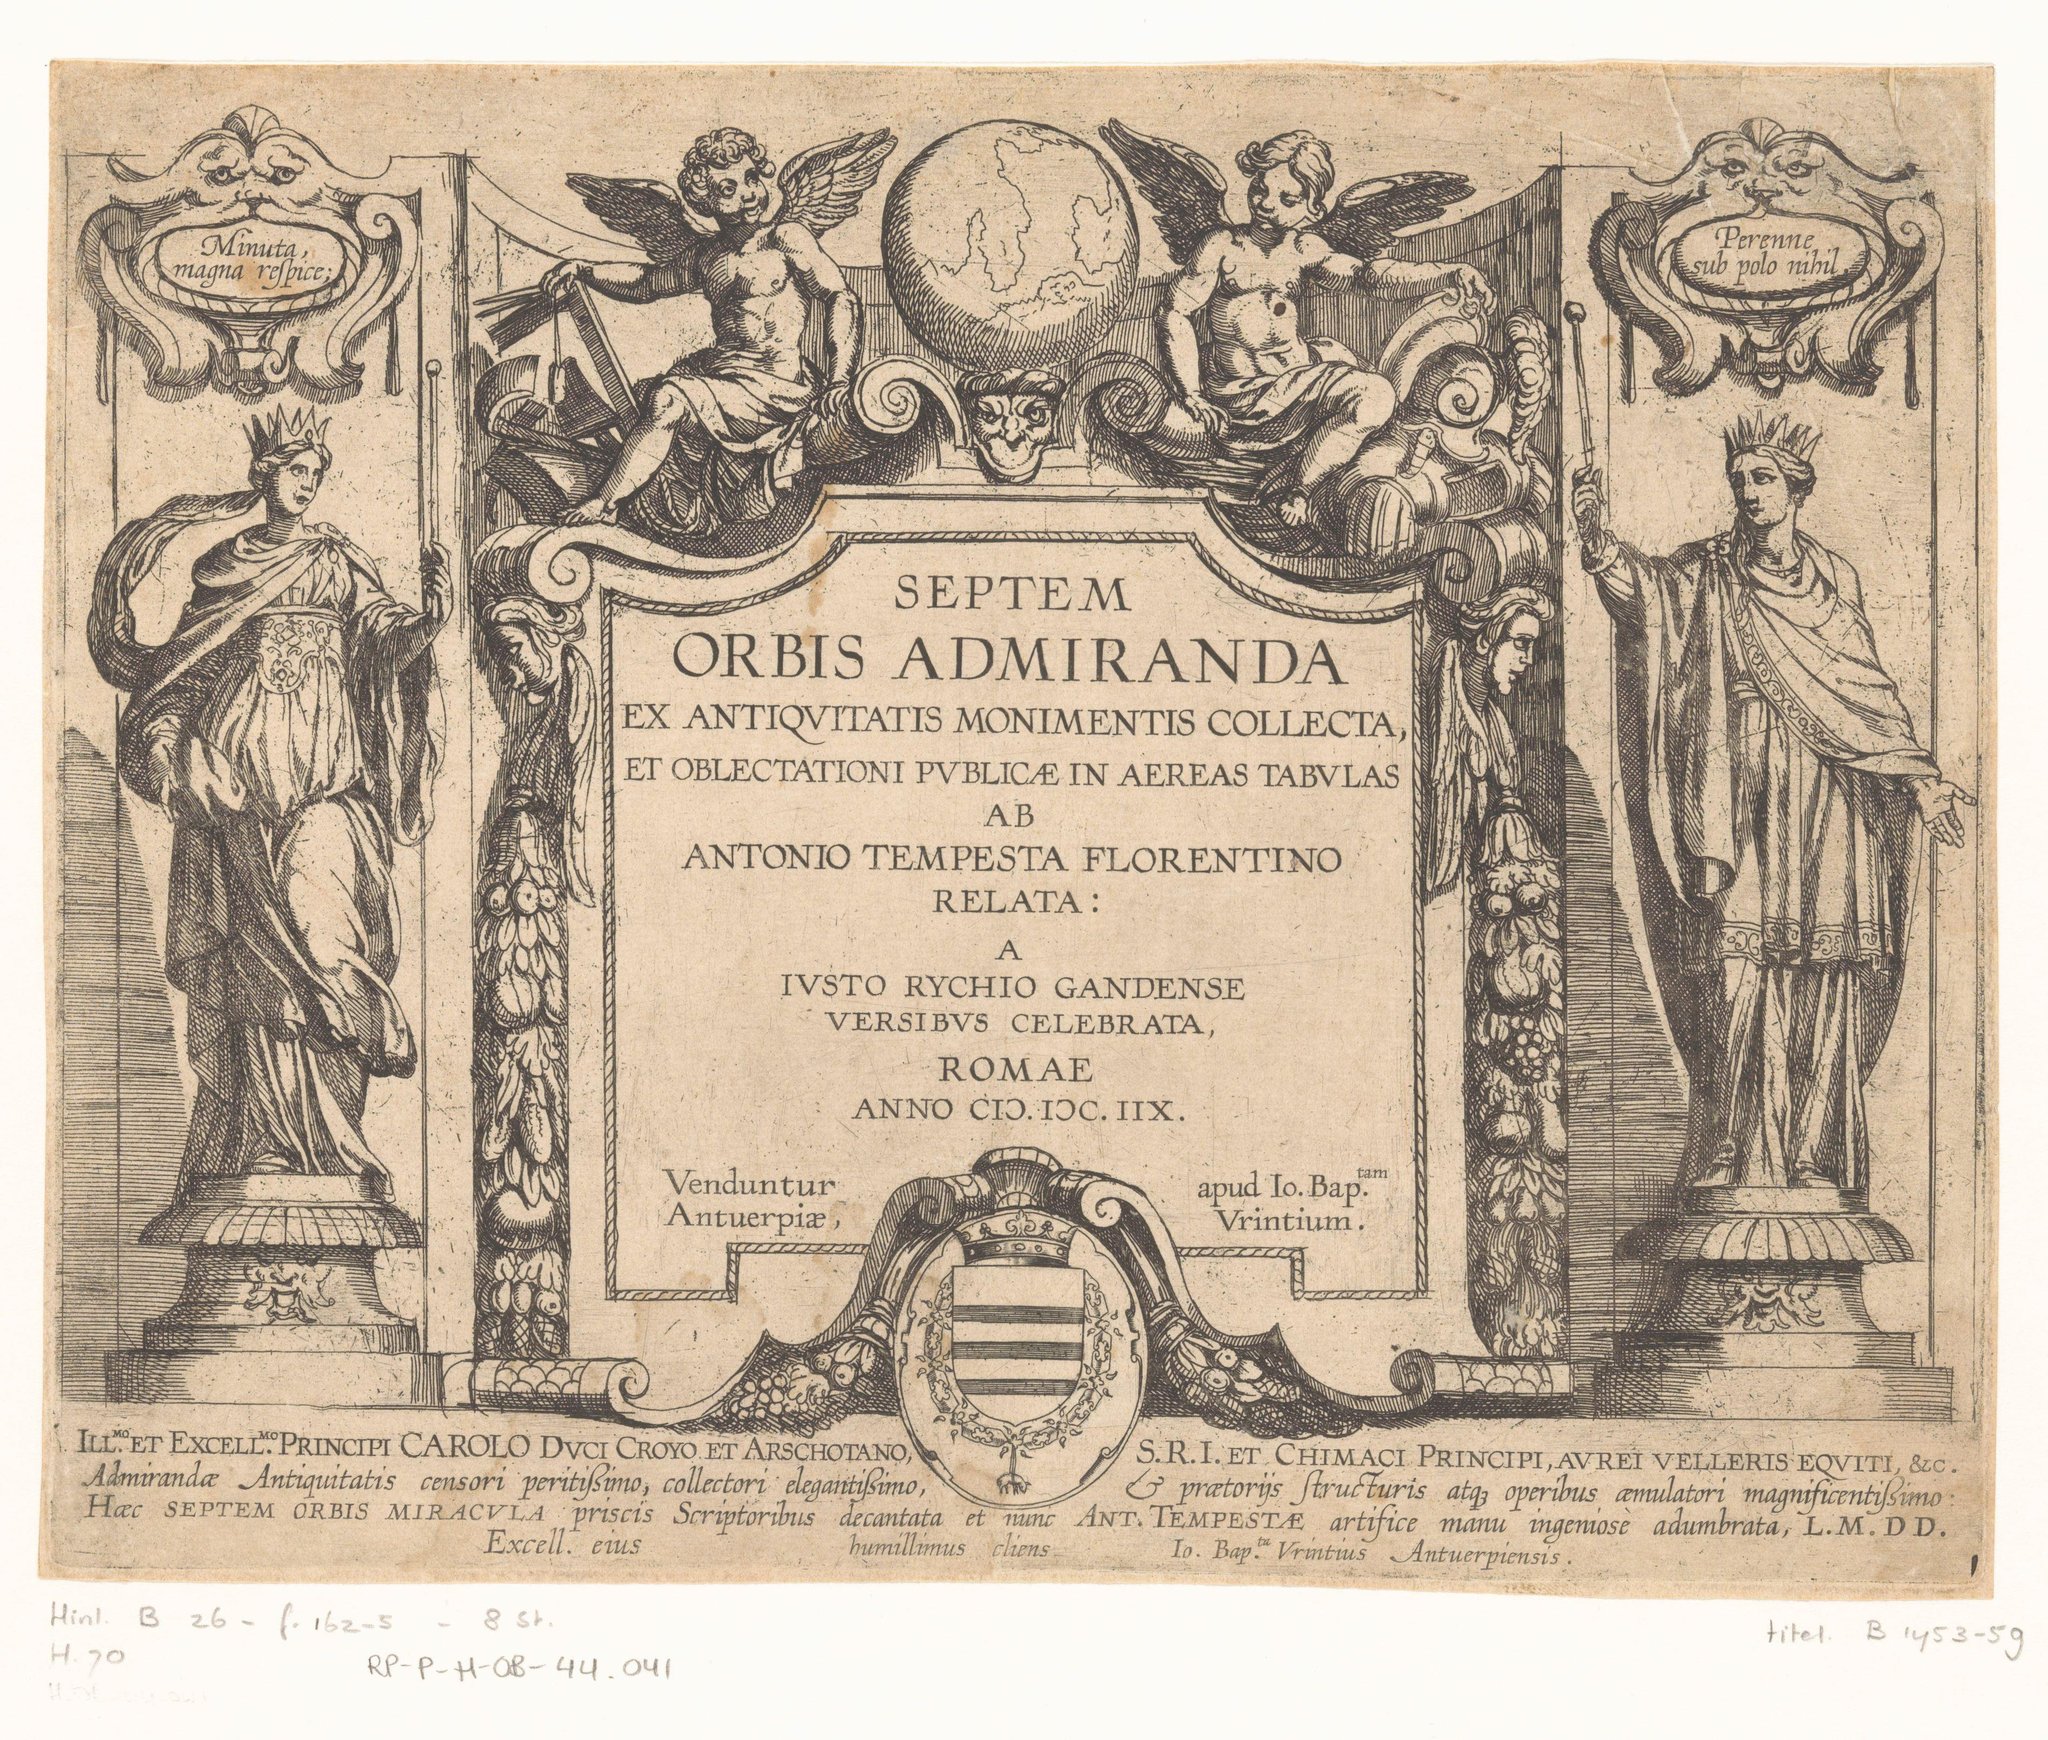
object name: titelprent, frontispice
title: Septem orbis admiranda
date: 1608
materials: paper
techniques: etching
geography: antwerp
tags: title-page, piece of sculpture, reproduction of a piece of sculpture, the seven wonders of the world, cupids: 'amores', 'amoretti', 'putti'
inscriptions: number: ‘1’, collector's mark: Lugt 11, collector's mark: ‘Hinloopen’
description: Titelprent bij een reeks van zeven prenten van de zeven wereldwonderen.